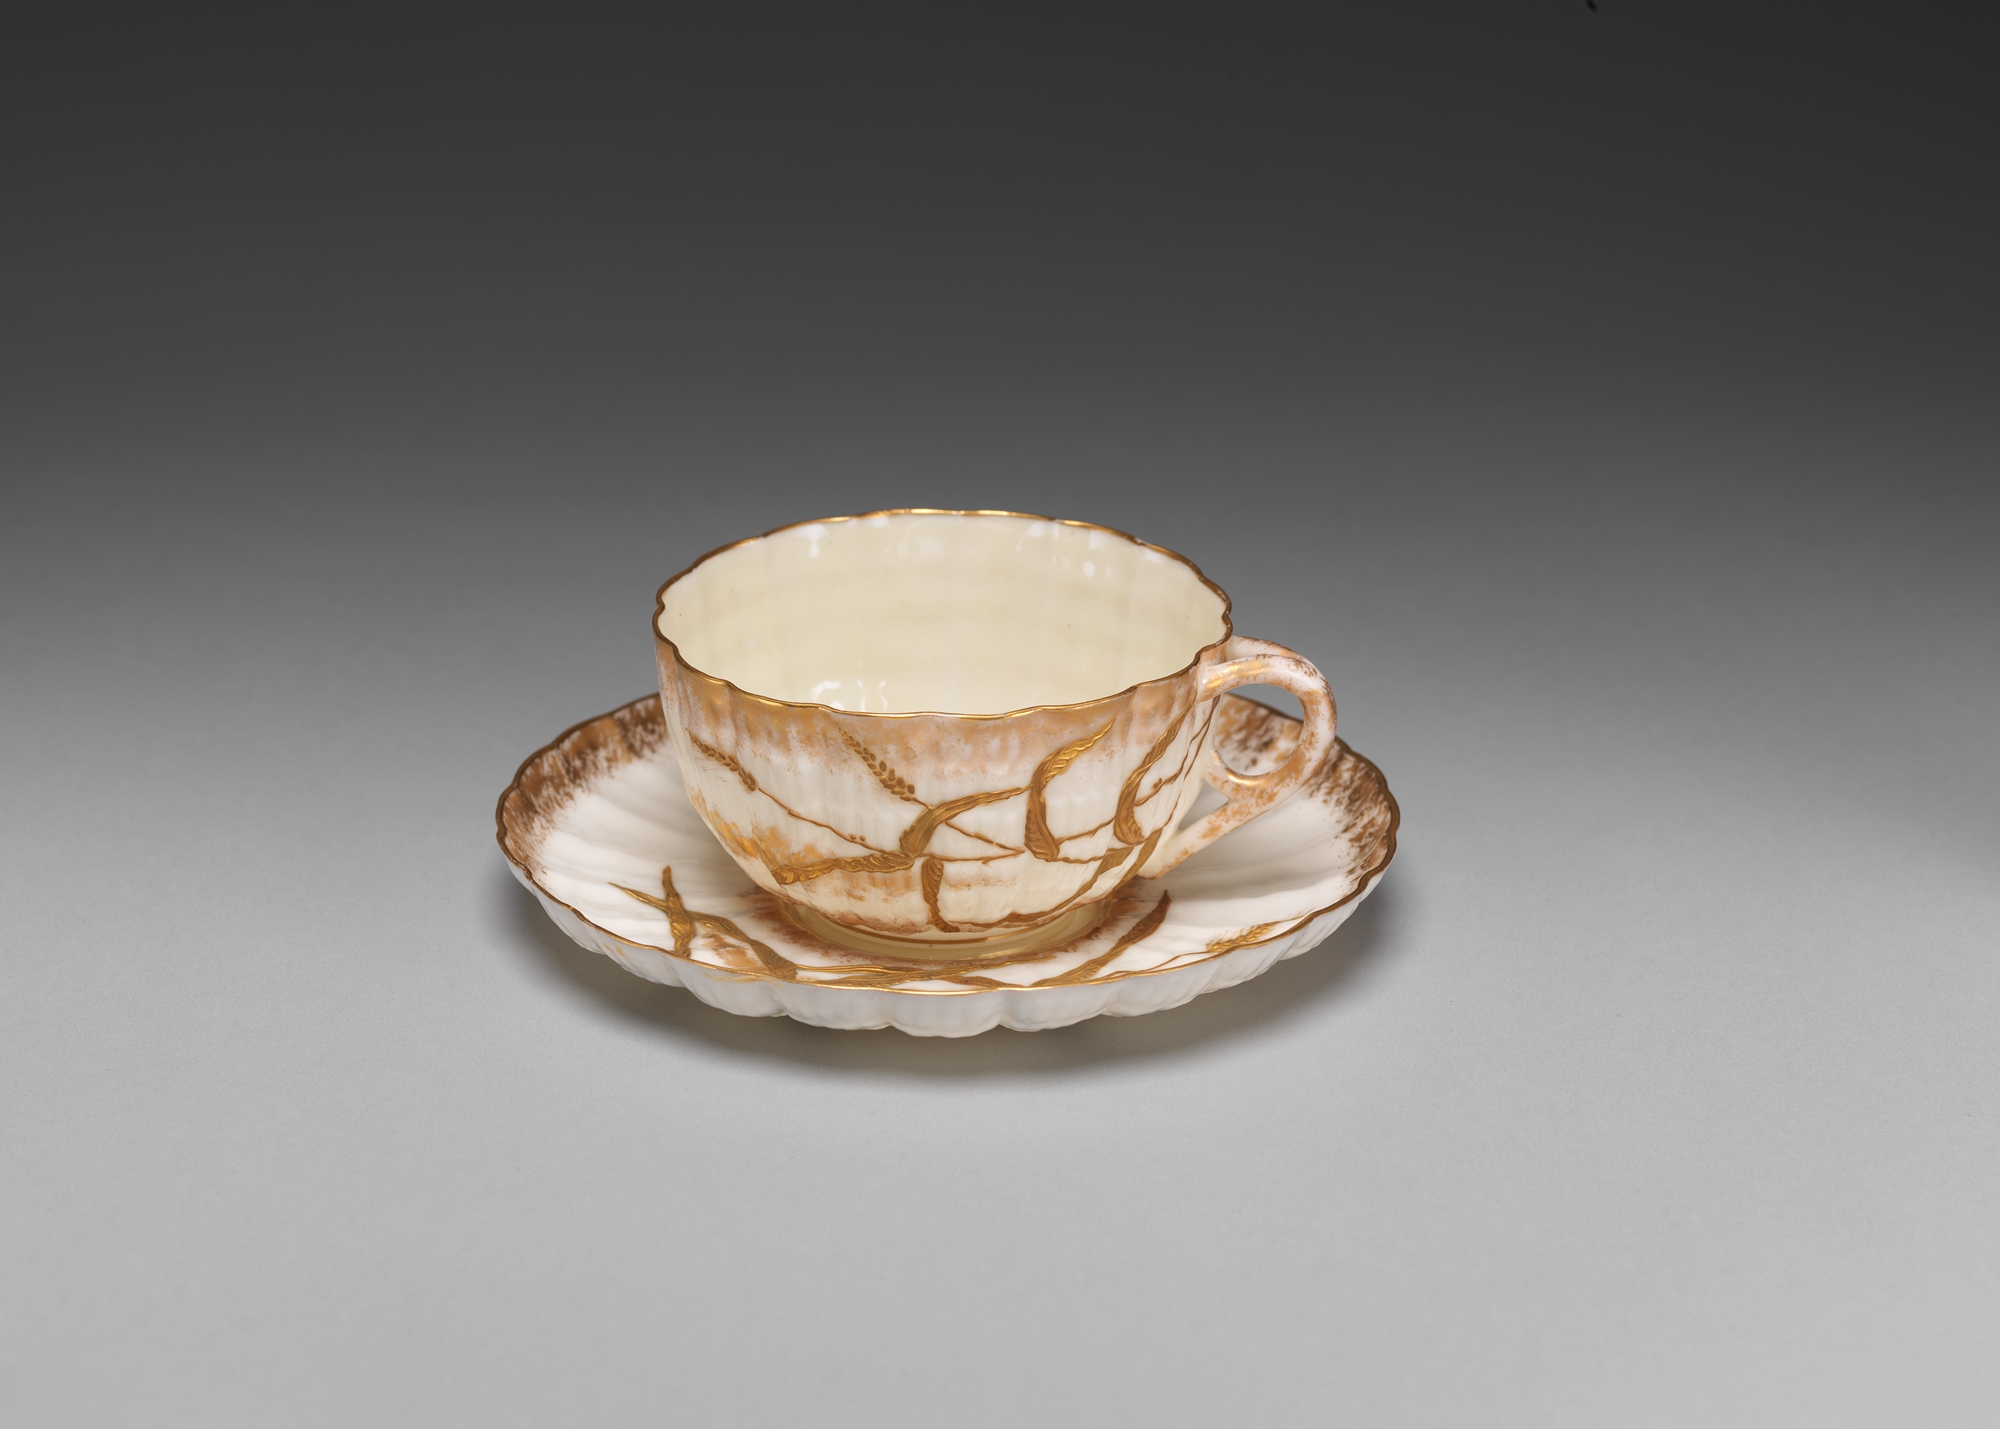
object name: cup and saucer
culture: american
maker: ott and brewer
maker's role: maker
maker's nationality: american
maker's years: 1871-1893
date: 1876-1892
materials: porcelain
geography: united states